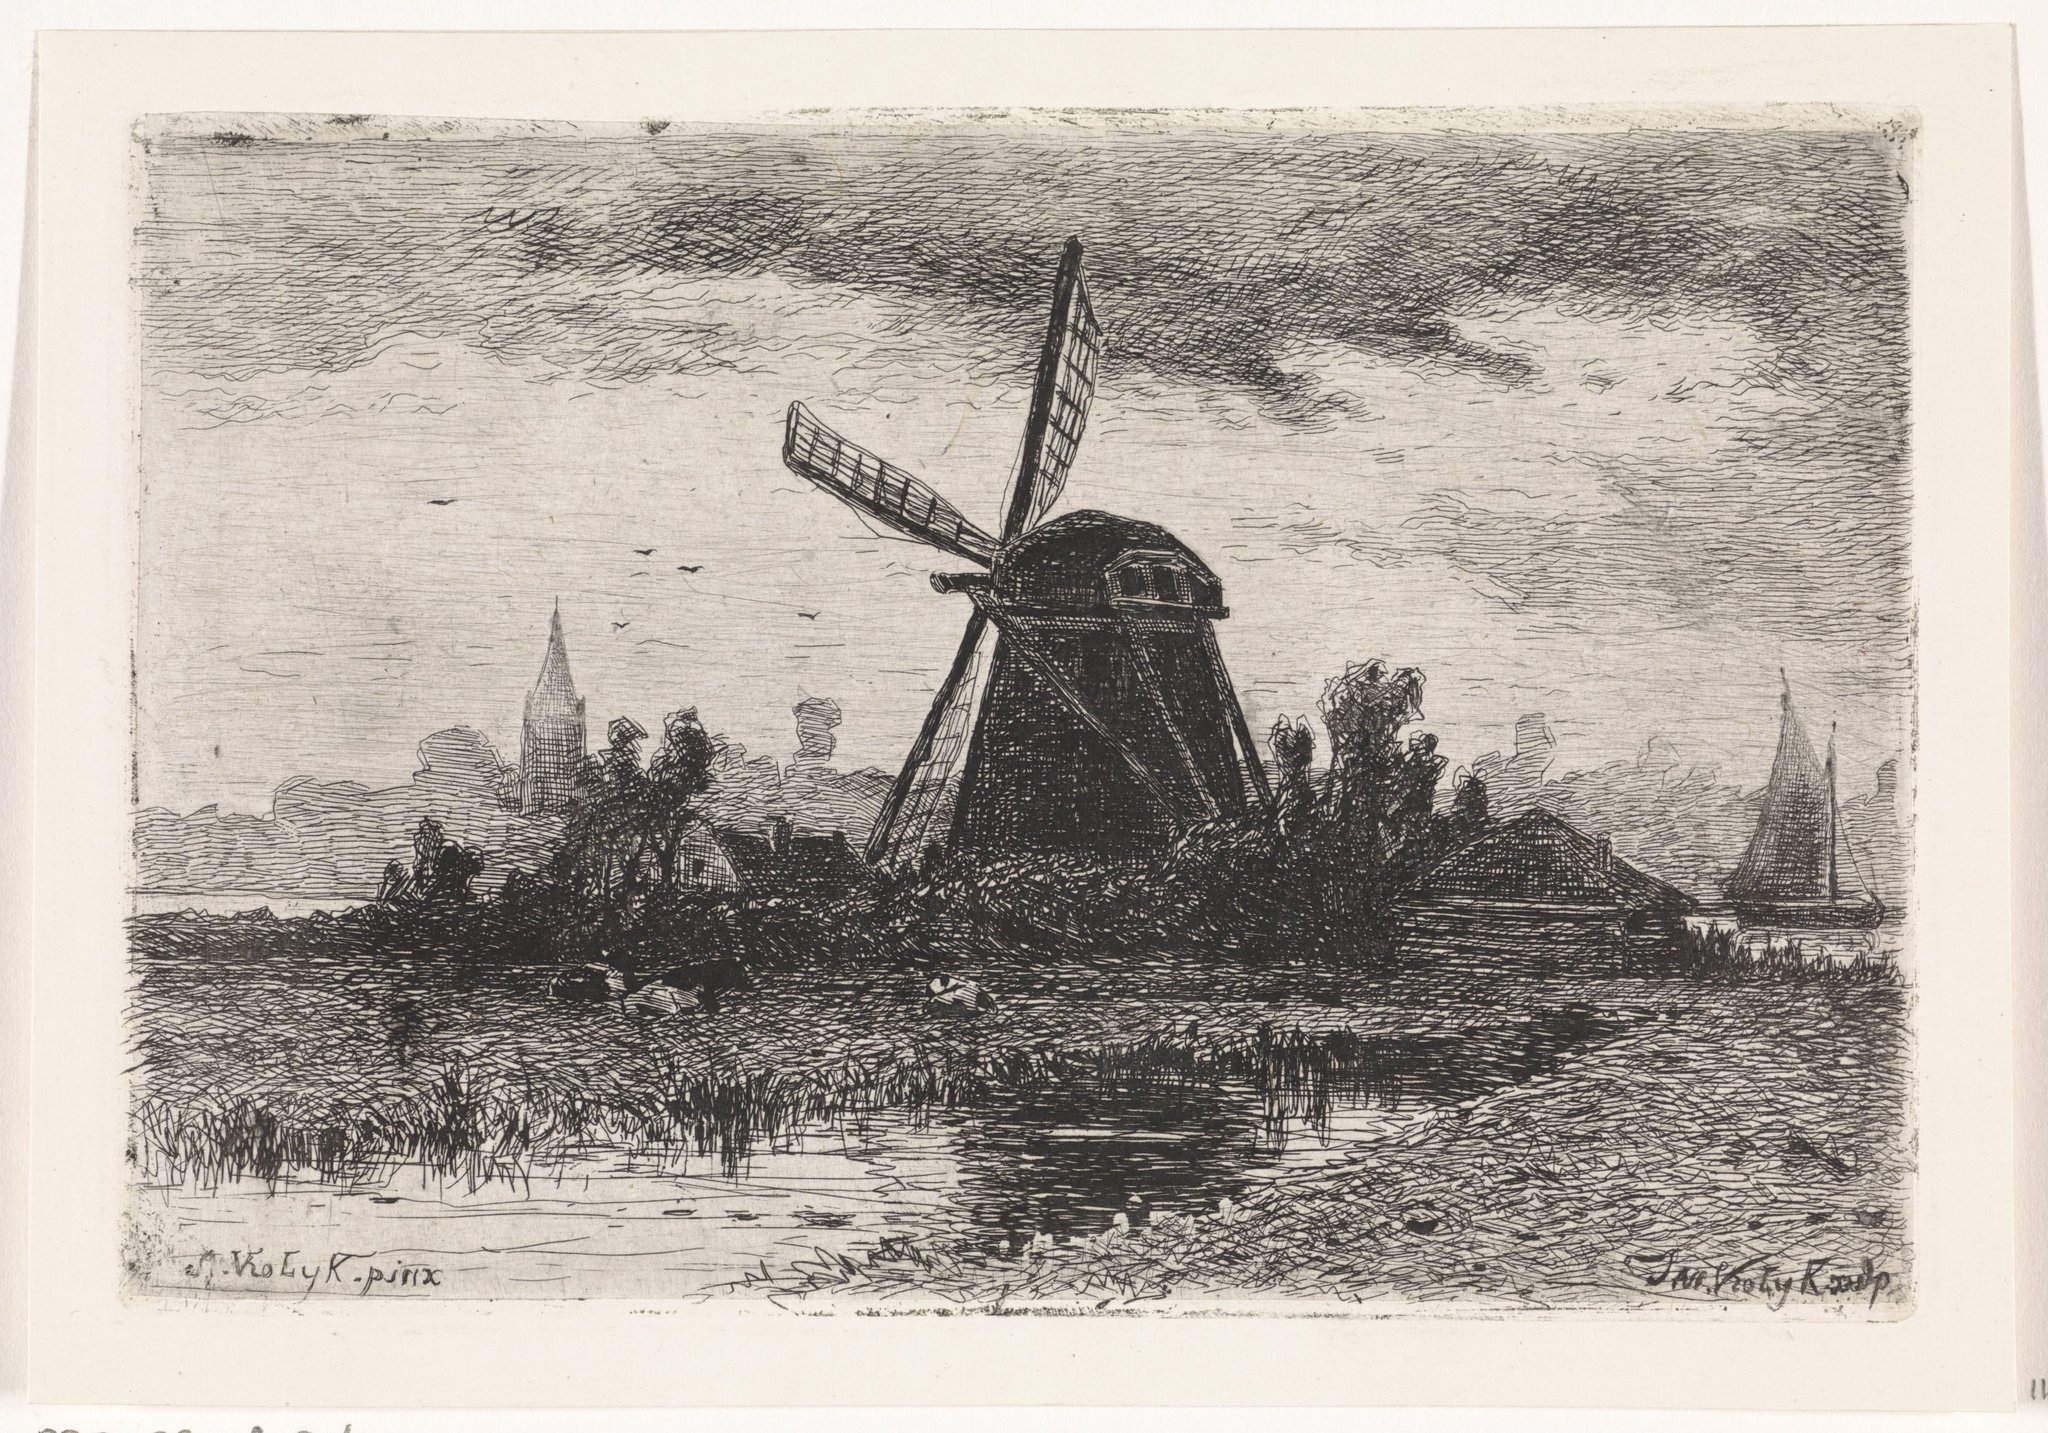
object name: print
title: Landschap met molen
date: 1860-1885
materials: paper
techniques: etching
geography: the hague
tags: windmill in landscape, small canal, ditch, parts of church exterior and annexes: tower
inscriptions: collector's mark: Lugt 2228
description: Gezicht op een molen, aan de rand van een weiland. Water op de voorgrond. Op de achtergrond een kerktoren.